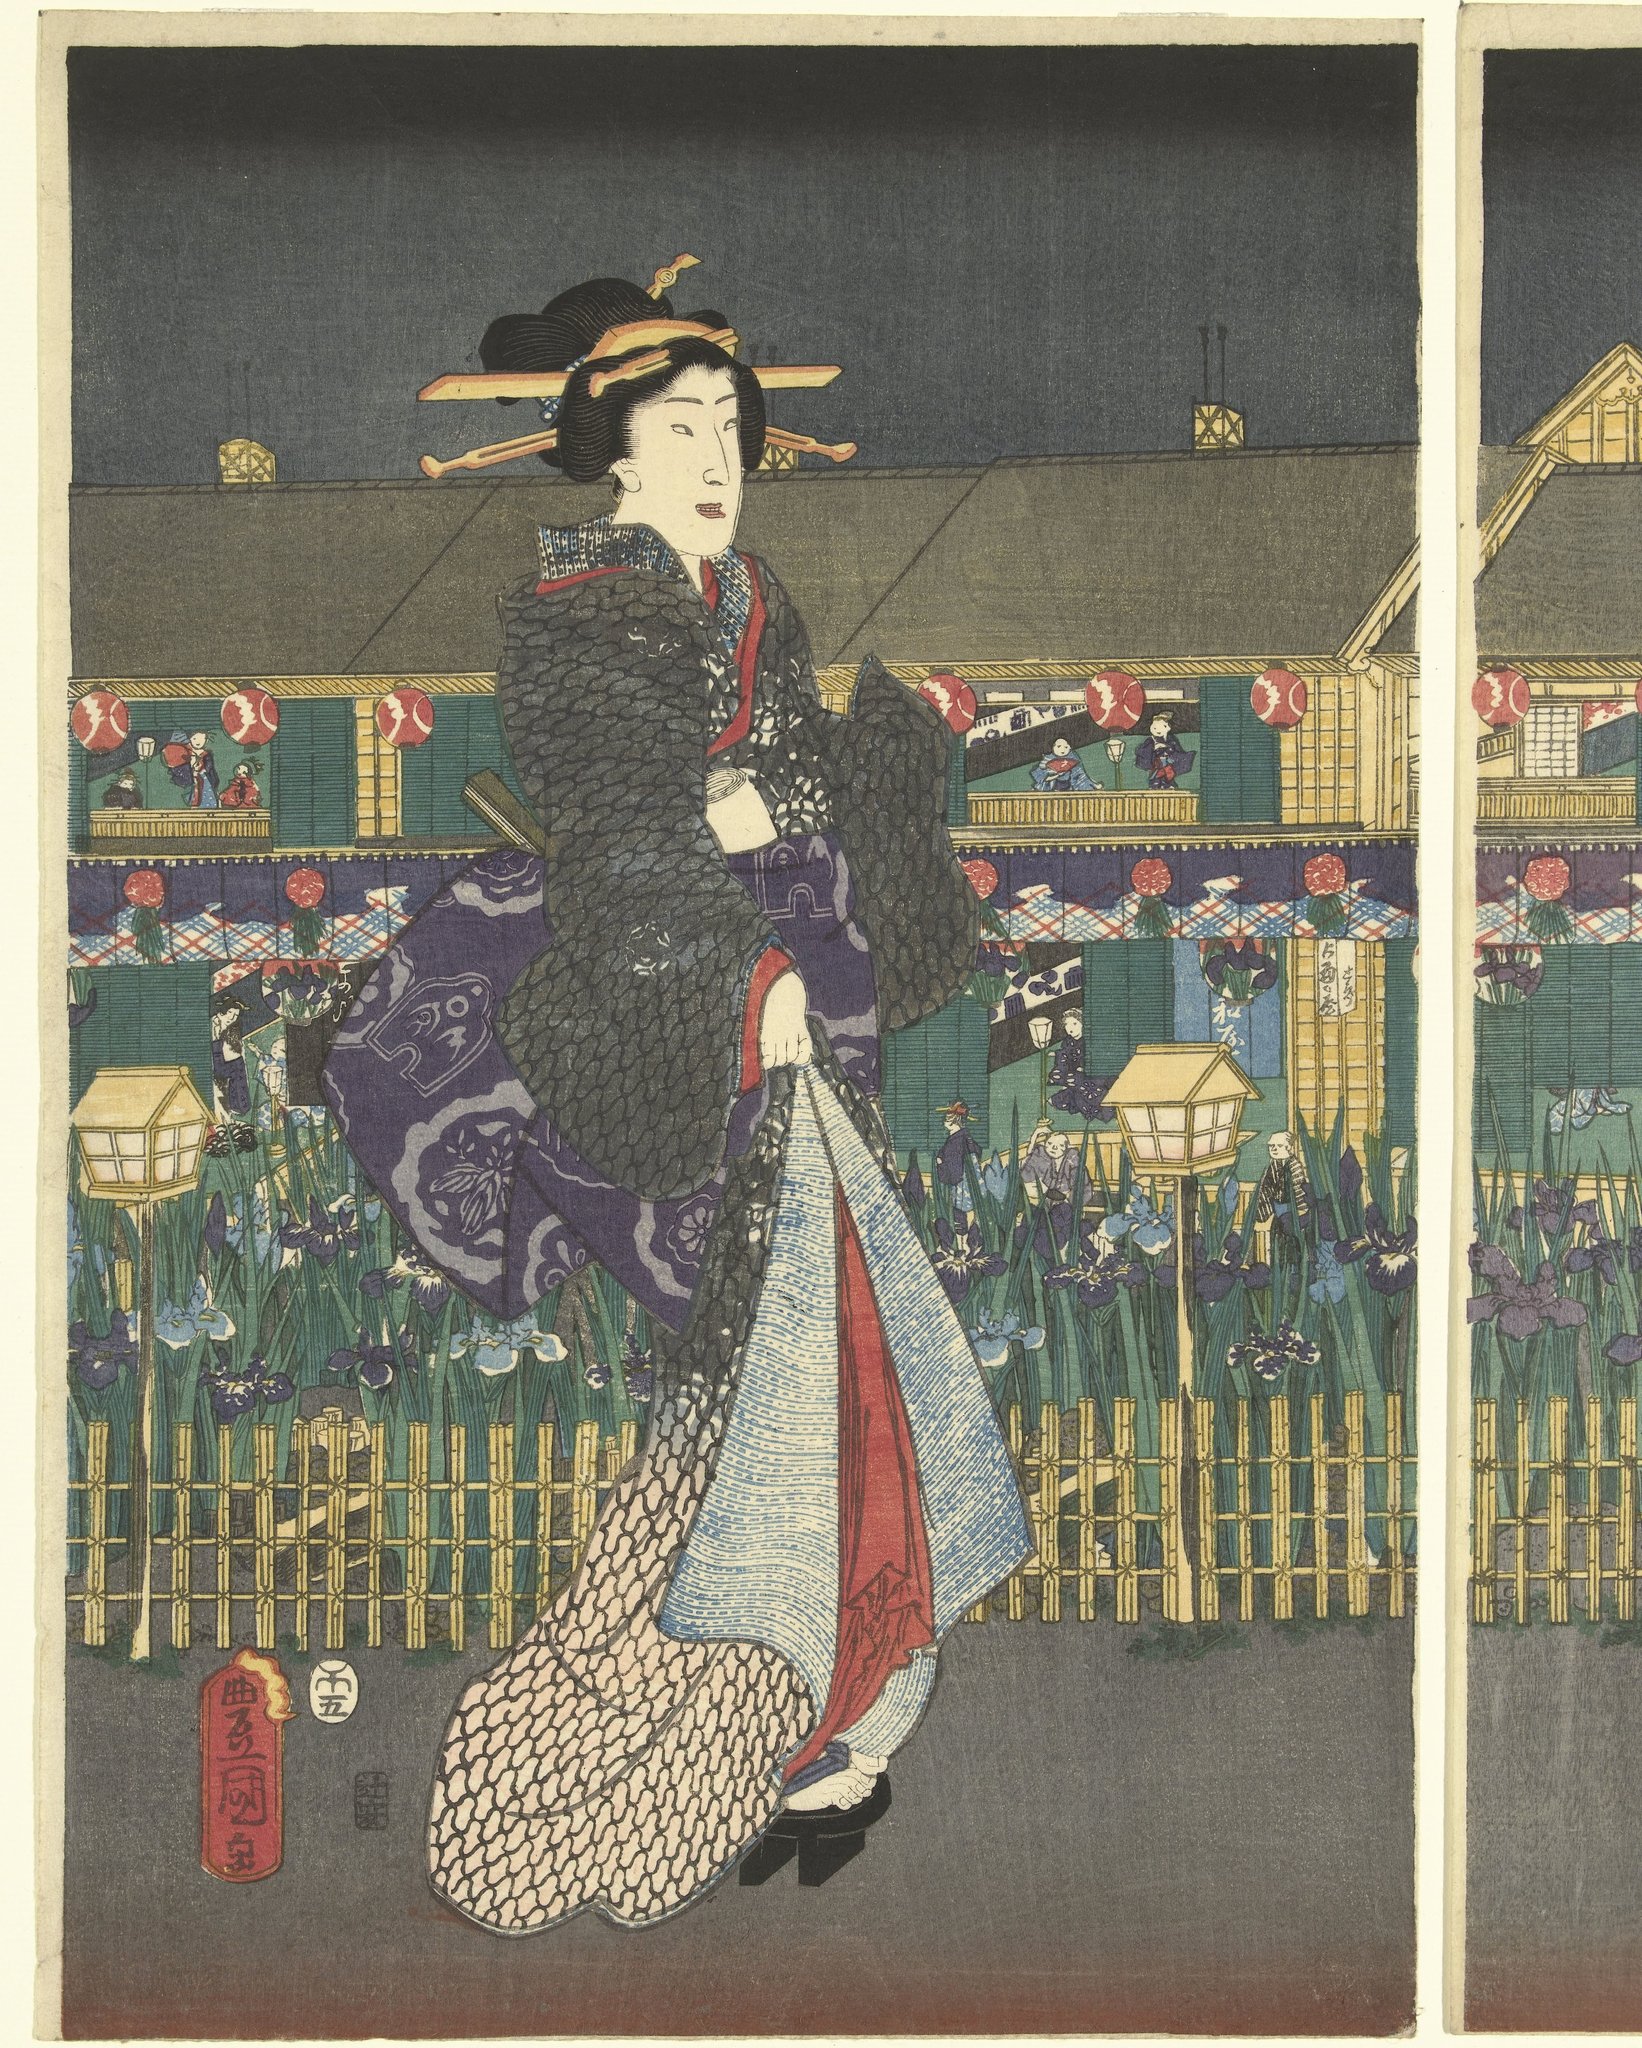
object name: print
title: Irissen in volle bloei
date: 1805-1858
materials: paper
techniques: woodcut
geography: japan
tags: adult woman, housing, street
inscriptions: date